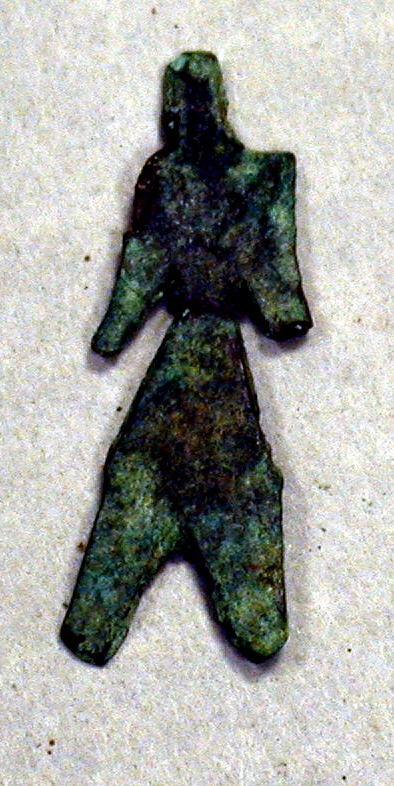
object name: figure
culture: middle niger civilization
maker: middle niger artist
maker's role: artist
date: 1101-1600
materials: copper alloy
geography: mali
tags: human figures